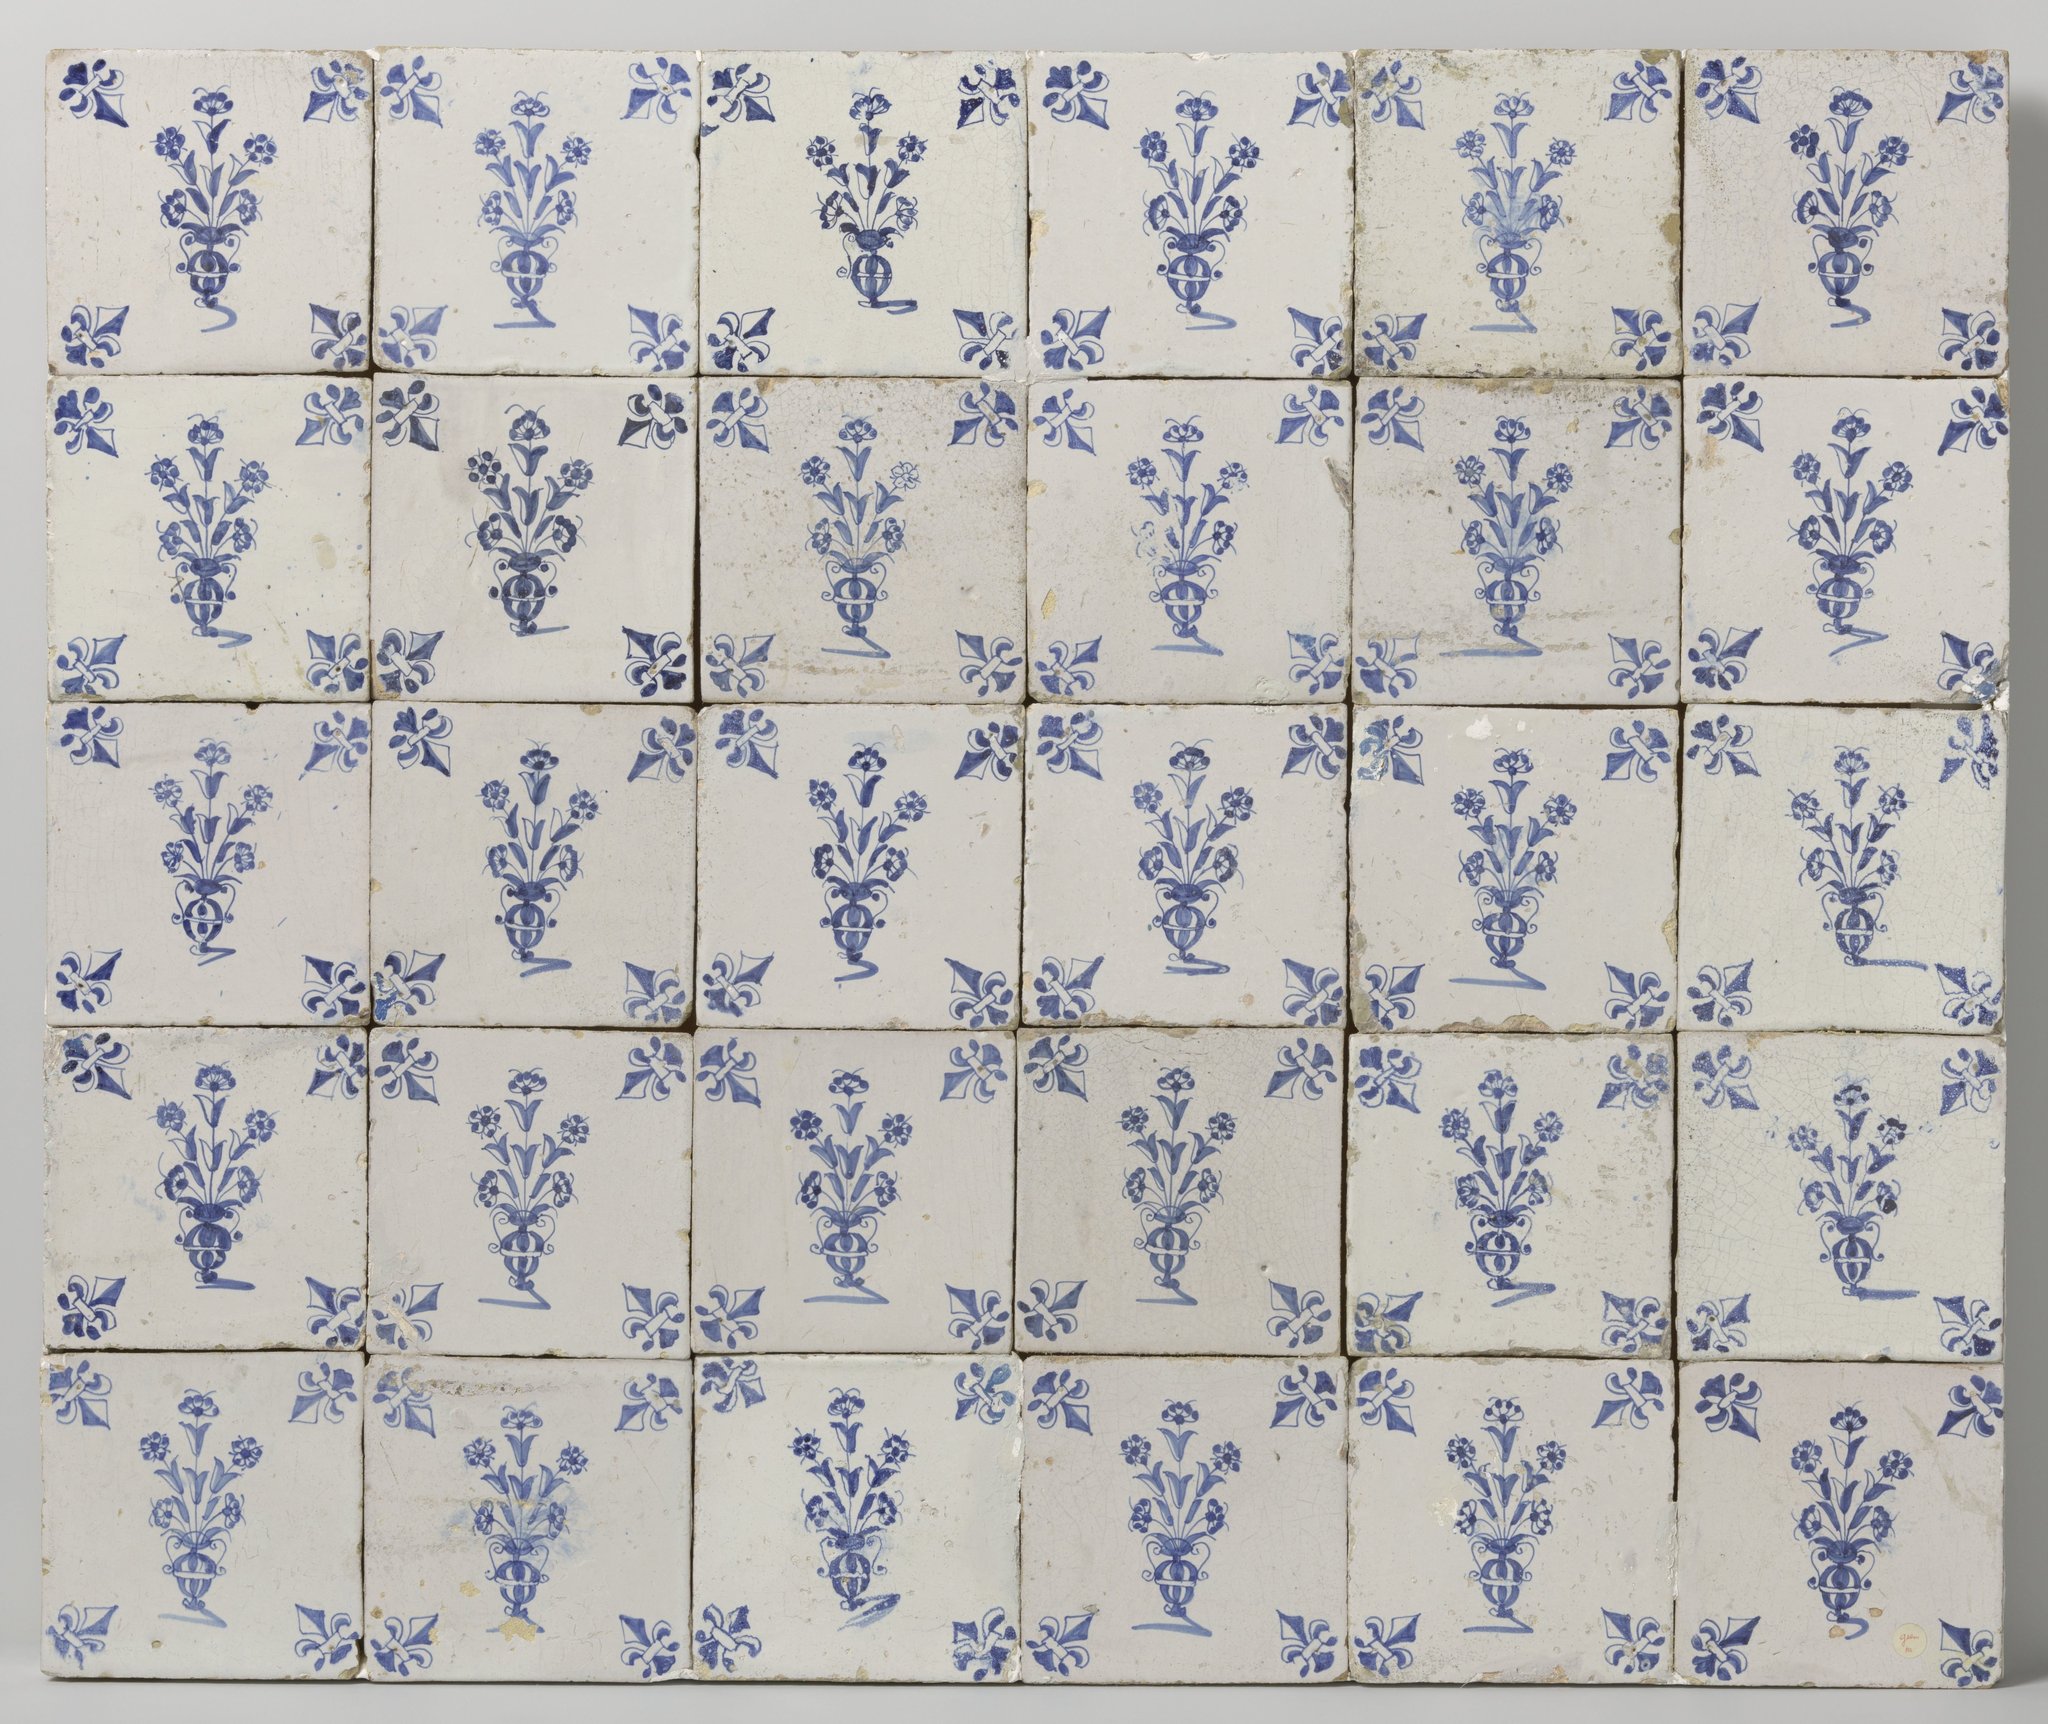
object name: tegelveld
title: Veld van dertig tegels met vazen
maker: Anonymous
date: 1640-1660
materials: earthenware, glaze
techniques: maiolica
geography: netherlands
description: Veld van dertig tegels (5 x 6) elk met een blauw geschilderde vaas. In de hoeken, een lelie. Oorspronkelijk was dit een veld van 48 tegels.